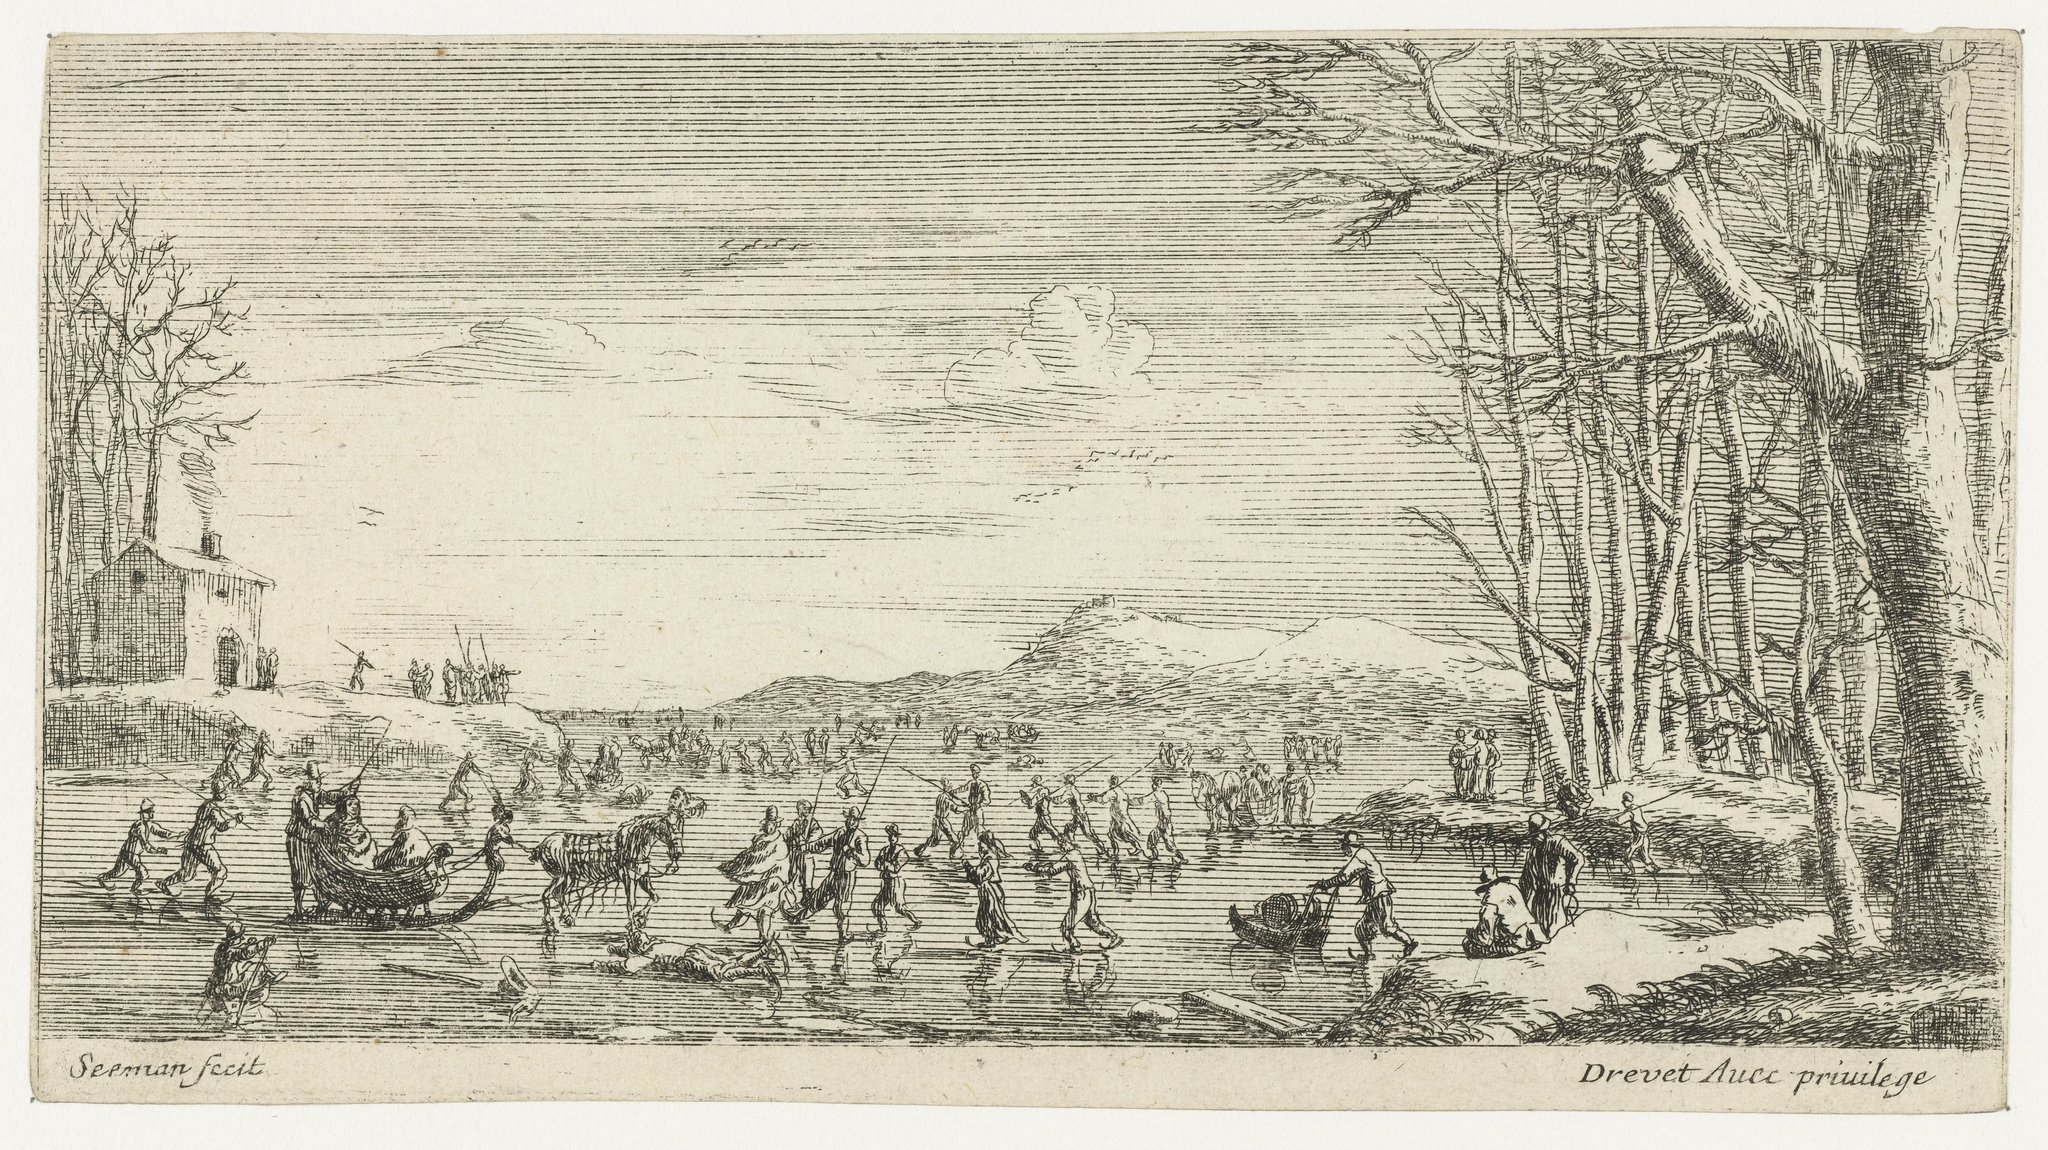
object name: print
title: Verschillende landschappen en zeegezichten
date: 1650-1738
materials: paper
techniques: etching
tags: skates (winter sports)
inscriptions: collector's mark: Lugt 2228a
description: Bevroren water in een heuvelig landschap bij een bosrand. Schaatsende mensen en arrensleeën op het ijs.